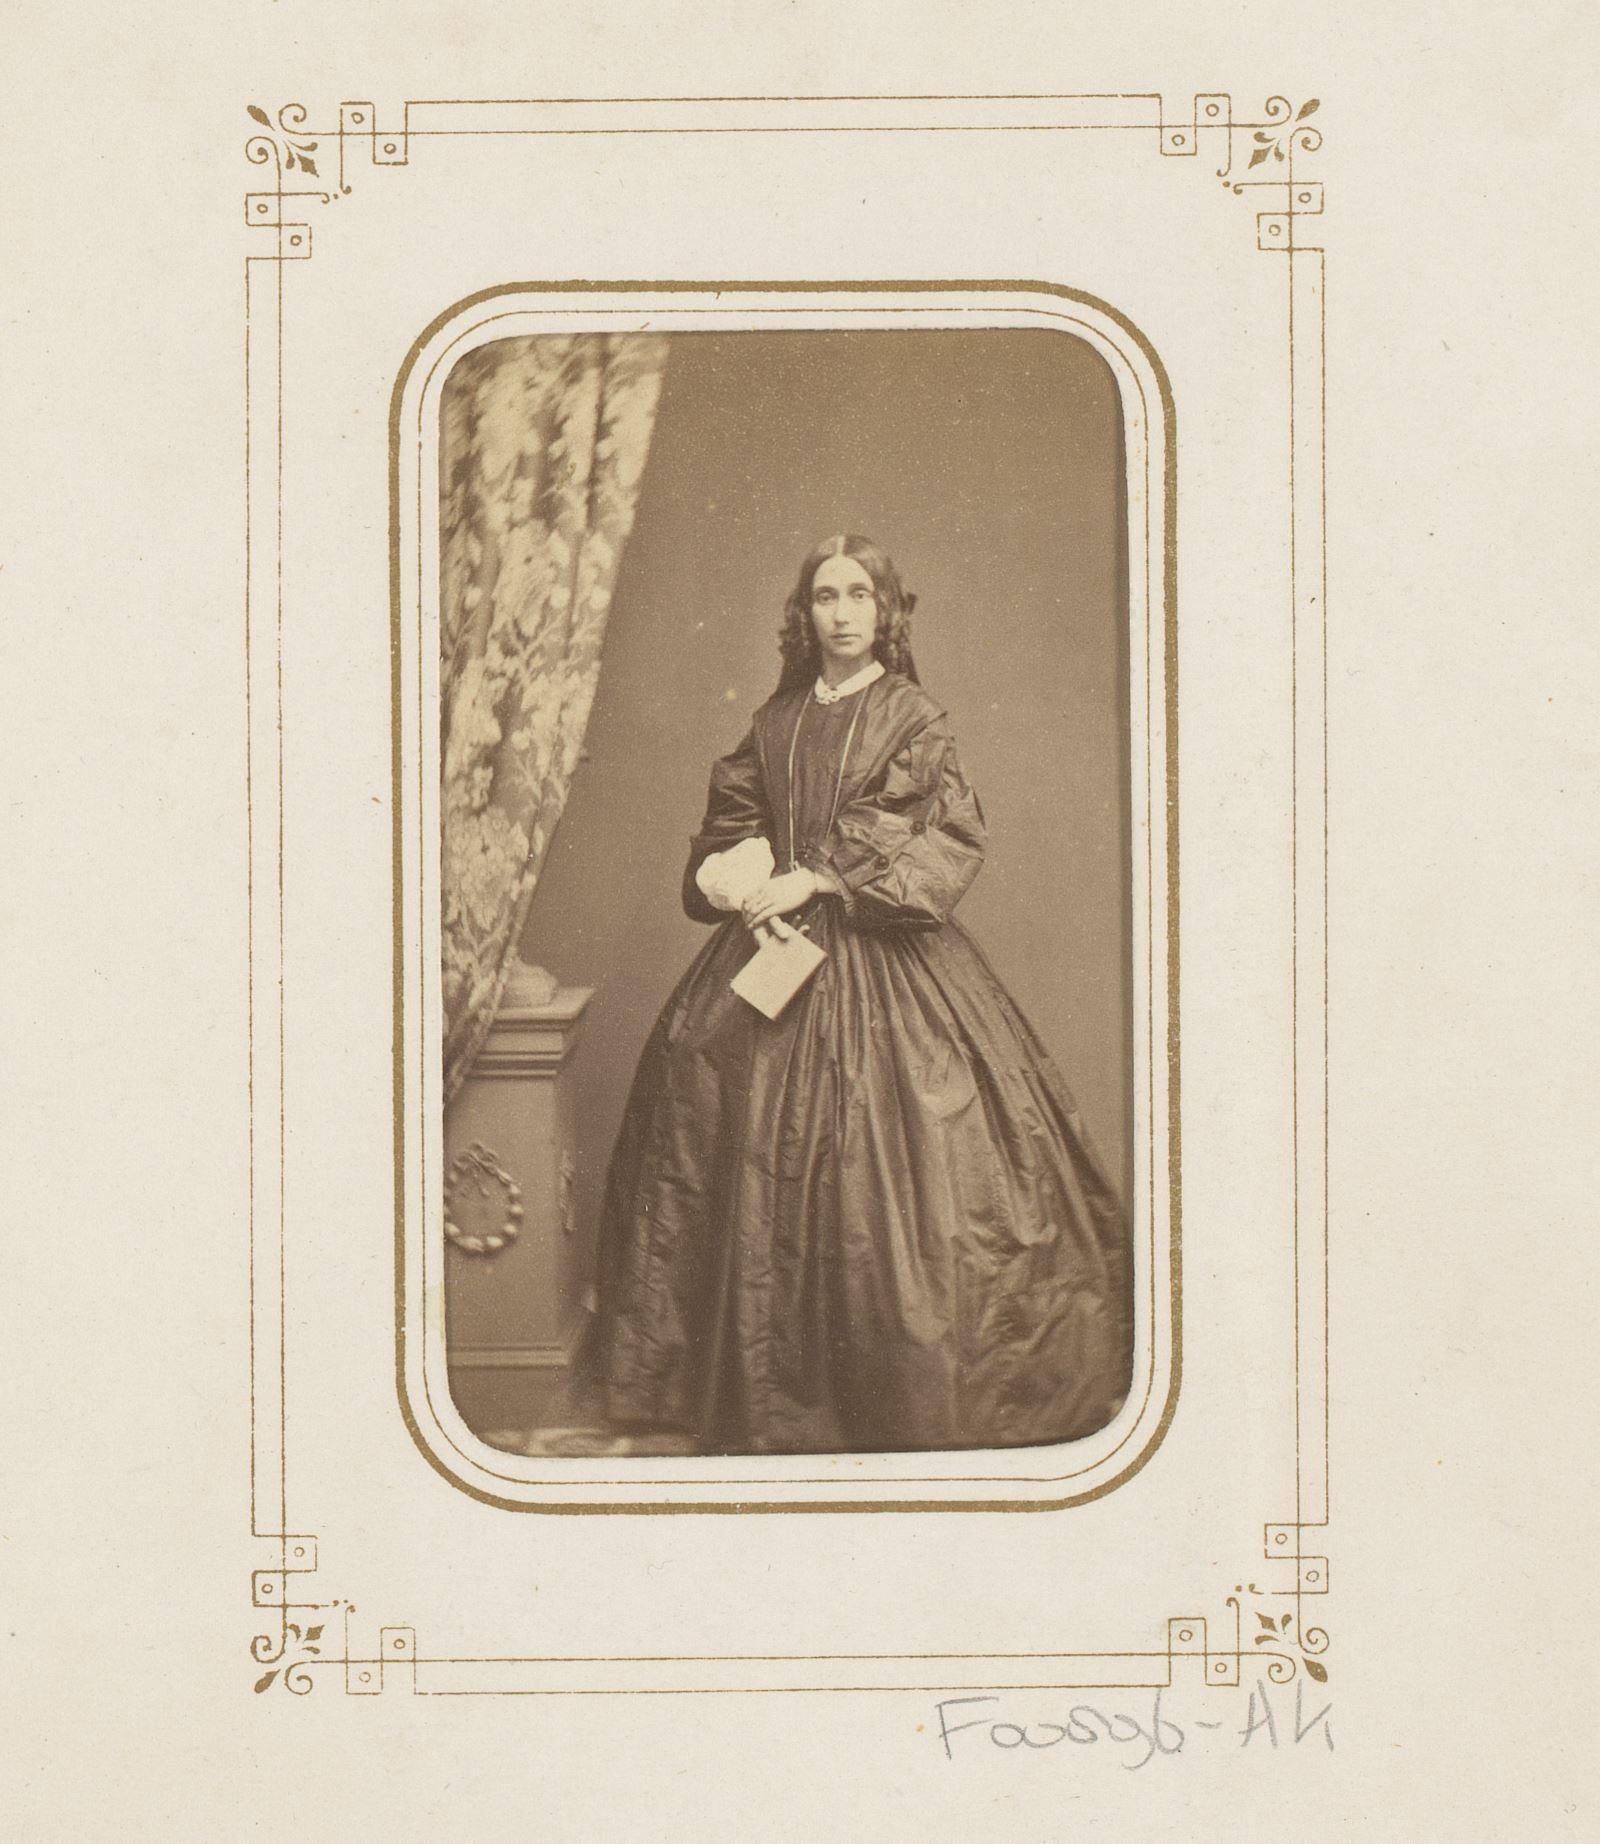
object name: album leaf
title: Portret van een vrouw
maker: Anonymous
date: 1855-1890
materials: cardboard, photographic support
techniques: albumen print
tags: historical persons, standing figure - aa - female human figure